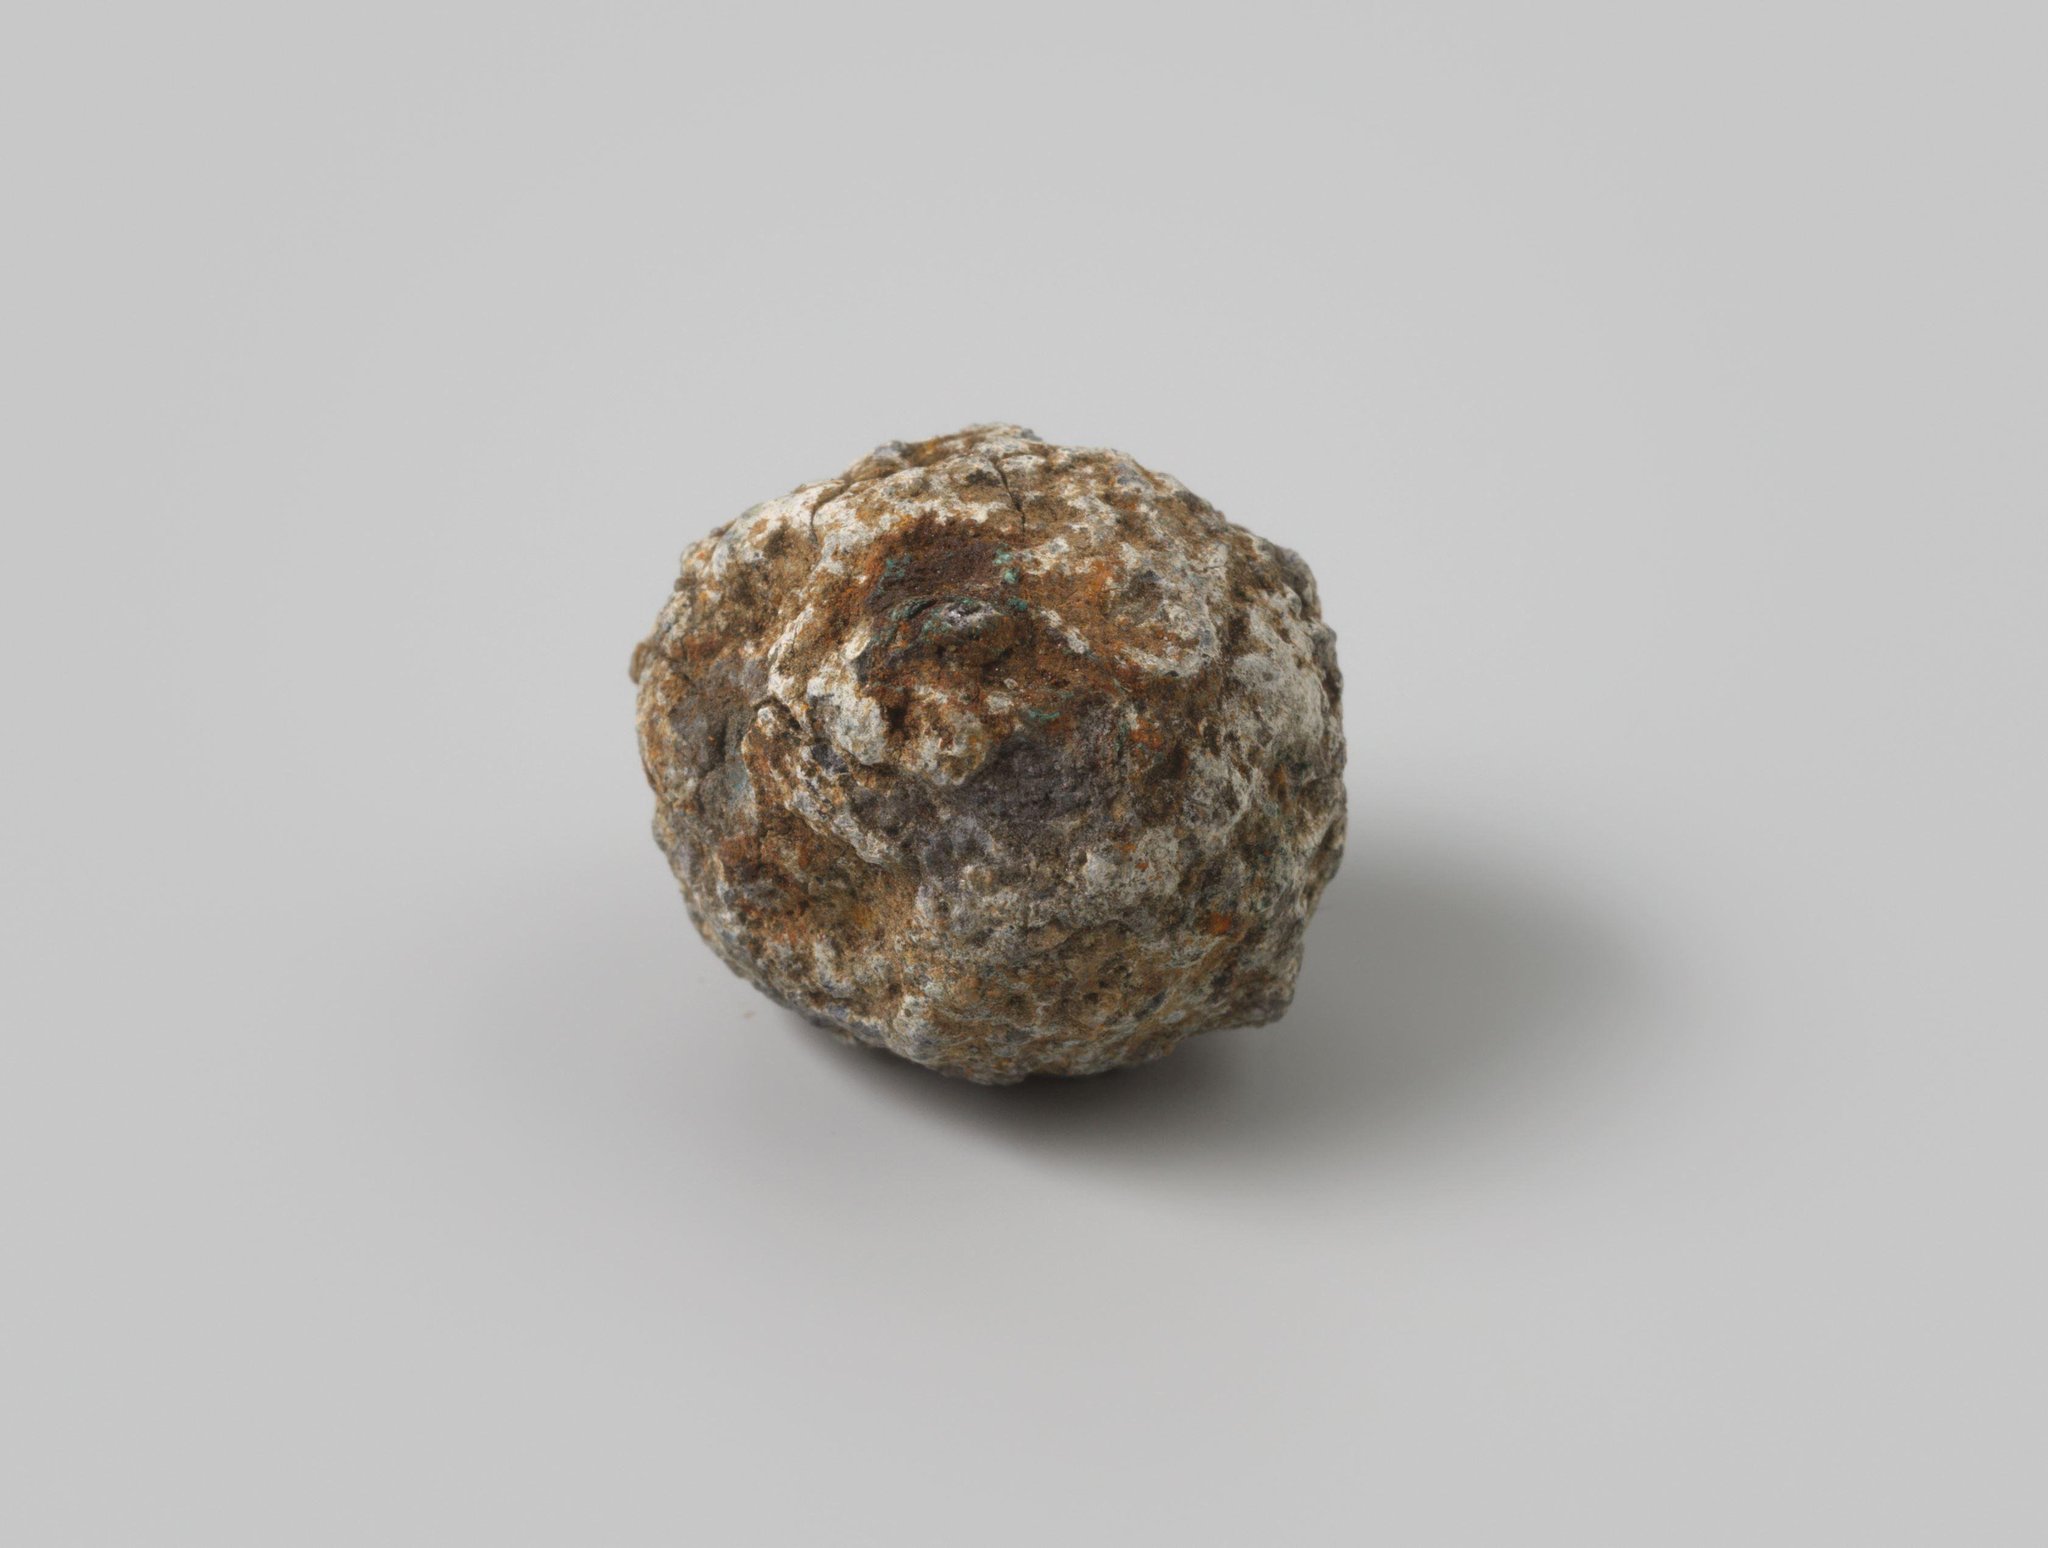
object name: musketkogel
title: Musketkogel uit het wrak van de Oost-Indiëvaarder Hollandia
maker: Anonymous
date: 1700-1743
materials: lead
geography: netherlands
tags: verenigde oostindische compagnie, hollandia (schip), annet